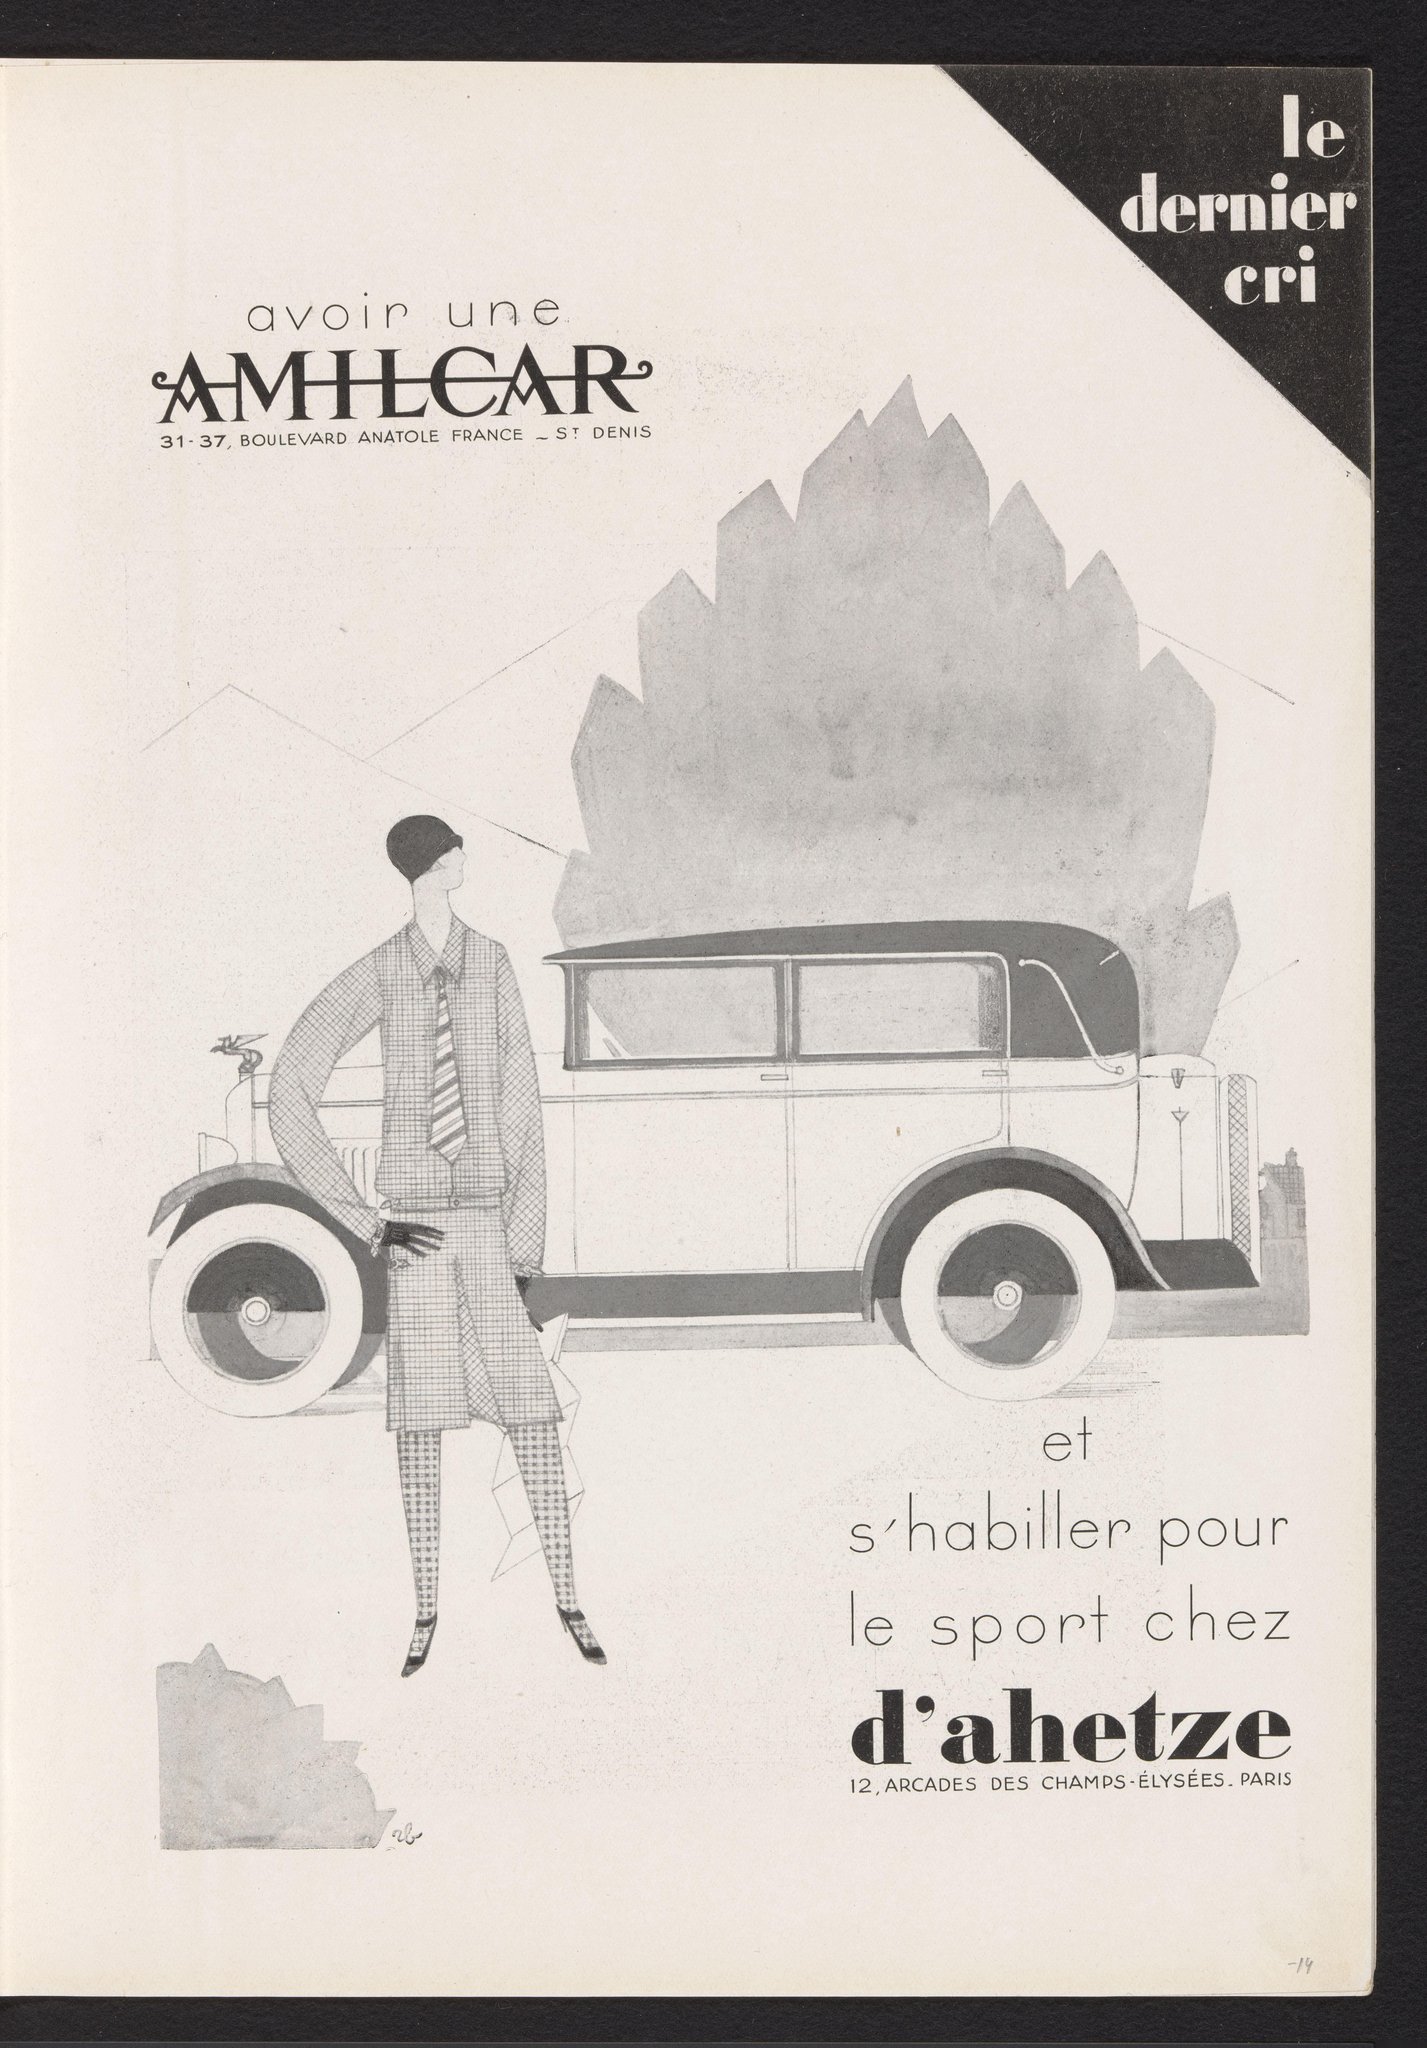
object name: fashion print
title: Femina, Mars 1928: advertentie voor sportkleding van Ahetze en een Amilcar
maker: pierre laffitte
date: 1928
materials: paper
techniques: photography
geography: paris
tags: fashion plates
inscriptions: title: ‘FEMINA’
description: Modetijdschrift Femina. Mars 1928. Een luxe Amilcar waarvoor een jonge vrouw in sportieve kledij: blouson met stropdas en rok tot op de knie in geruite stof. Cloche op het korte haar. Plattegrond in de hand.